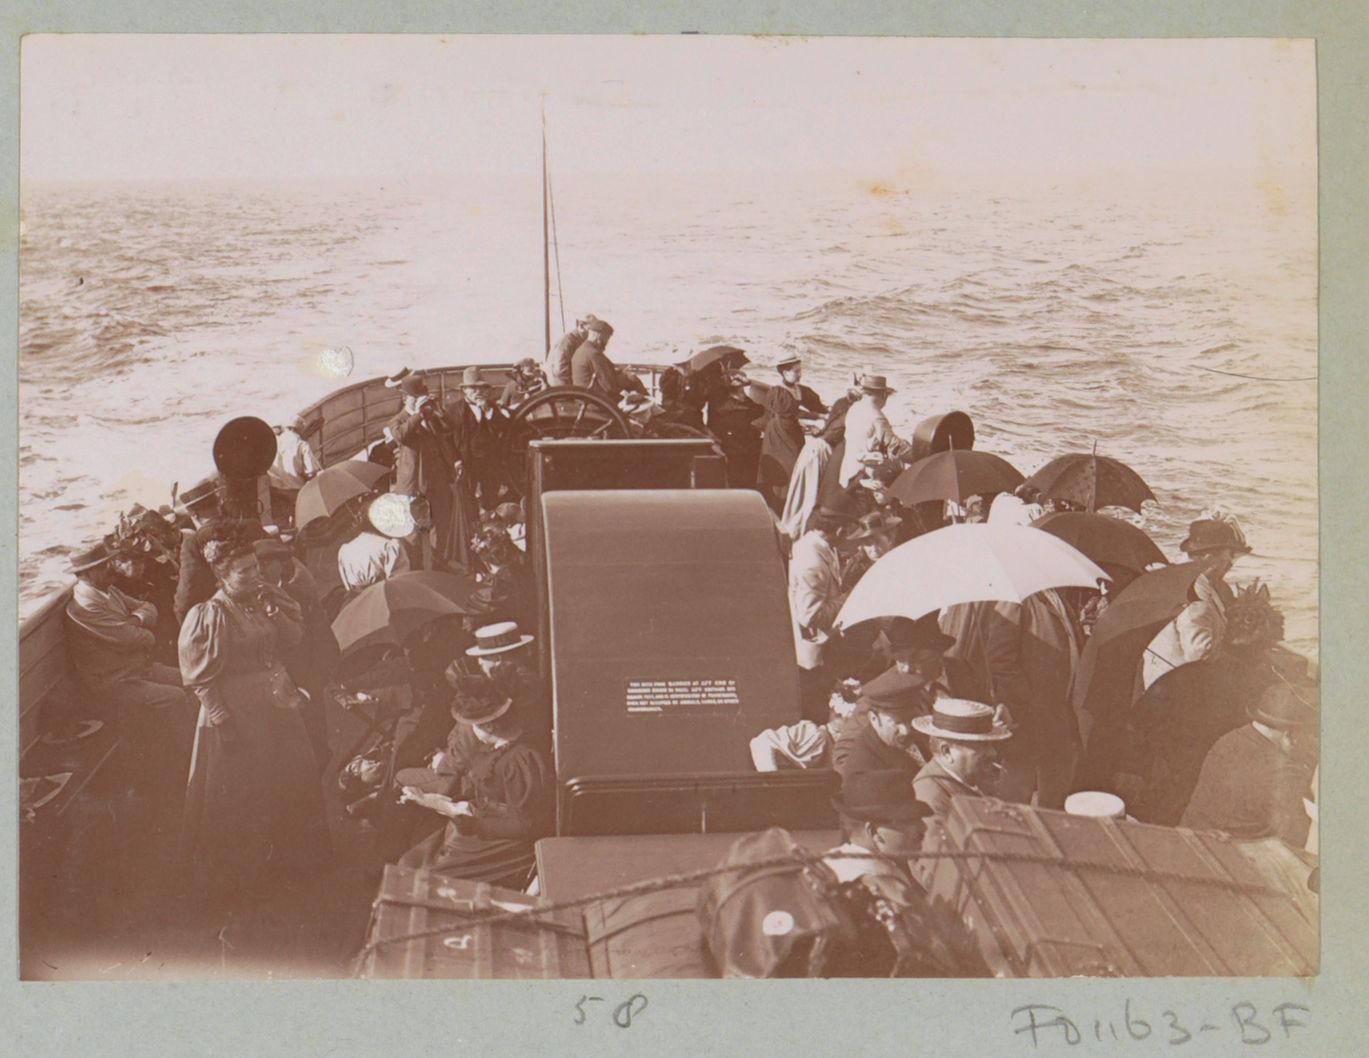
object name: photograph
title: Mensen op het dek van een schip, in de buurt van Saint-Malo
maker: delizy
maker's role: manufacturer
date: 1896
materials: paper, photographic support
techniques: gelatin silver print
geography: saint-malo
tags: parts of ship's exterior: deck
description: Onderdeel van Fotoalbum van een Franse amateurfotograaf met opnames van uitstapjes in Frankrijk, Spanje, België, Luxemburg en Nederland, de eerste automobielen en autoraces.